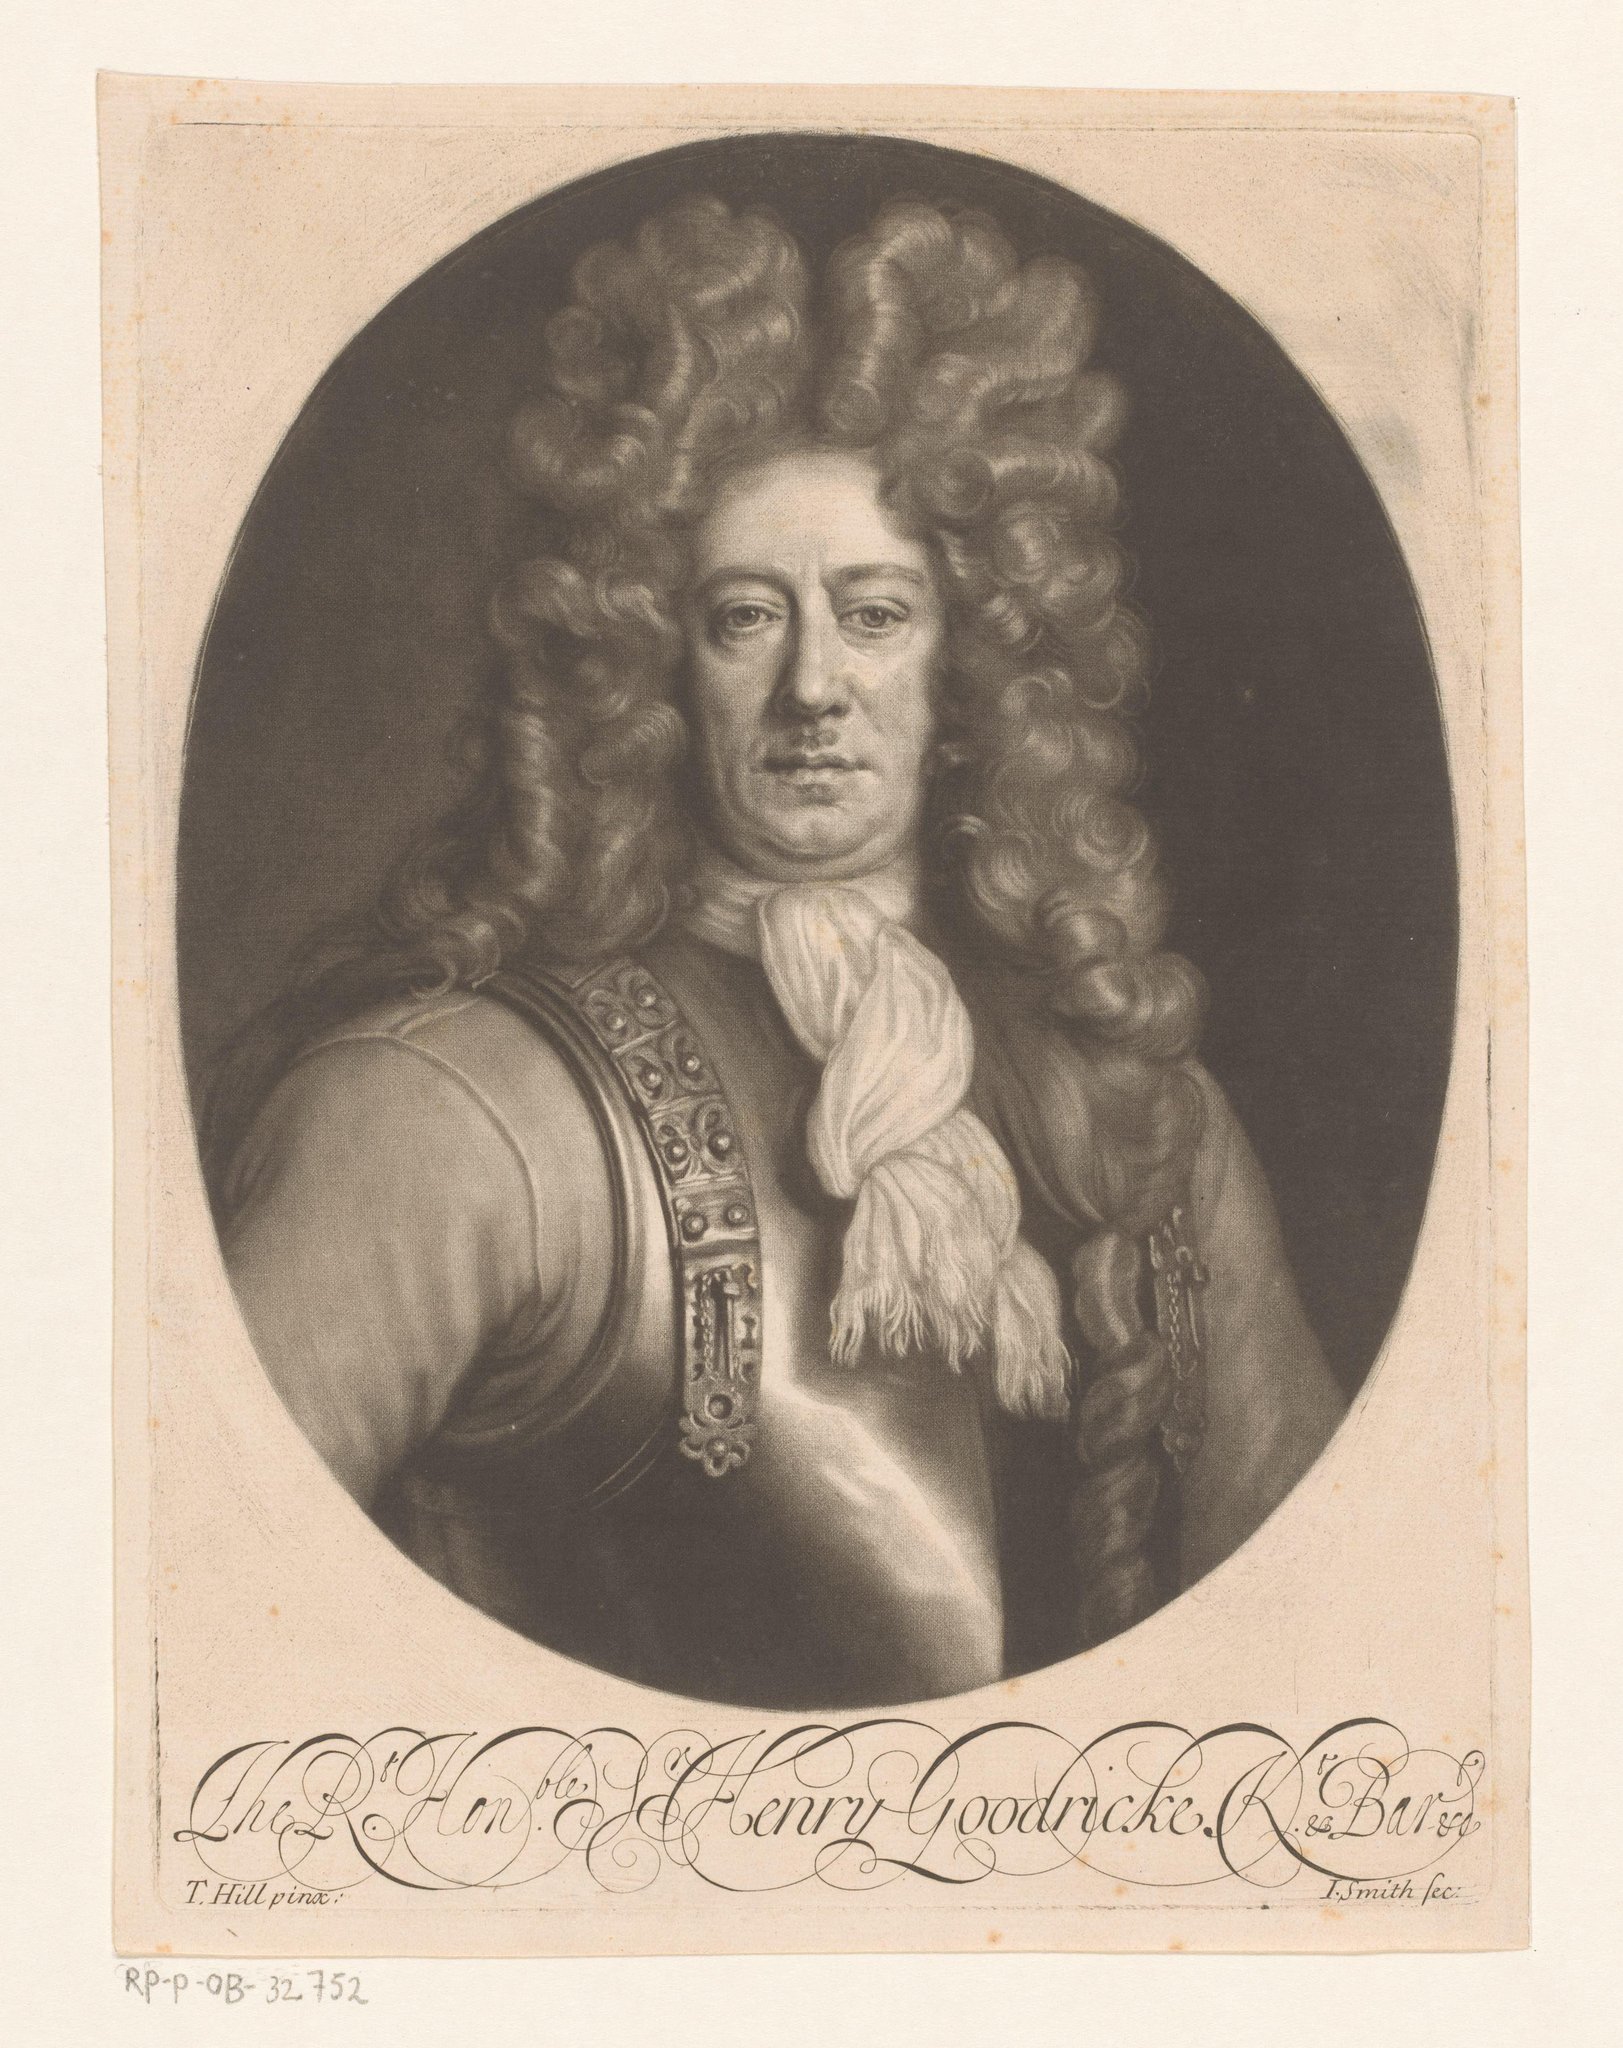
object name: print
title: Portret van Henry Goodricke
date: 1662-1742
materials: paper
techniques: mezzotint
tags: politician, historical persons, politician, e.g. party leader, diplomacy, diplomat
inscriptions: collector's mark: Lugt 240